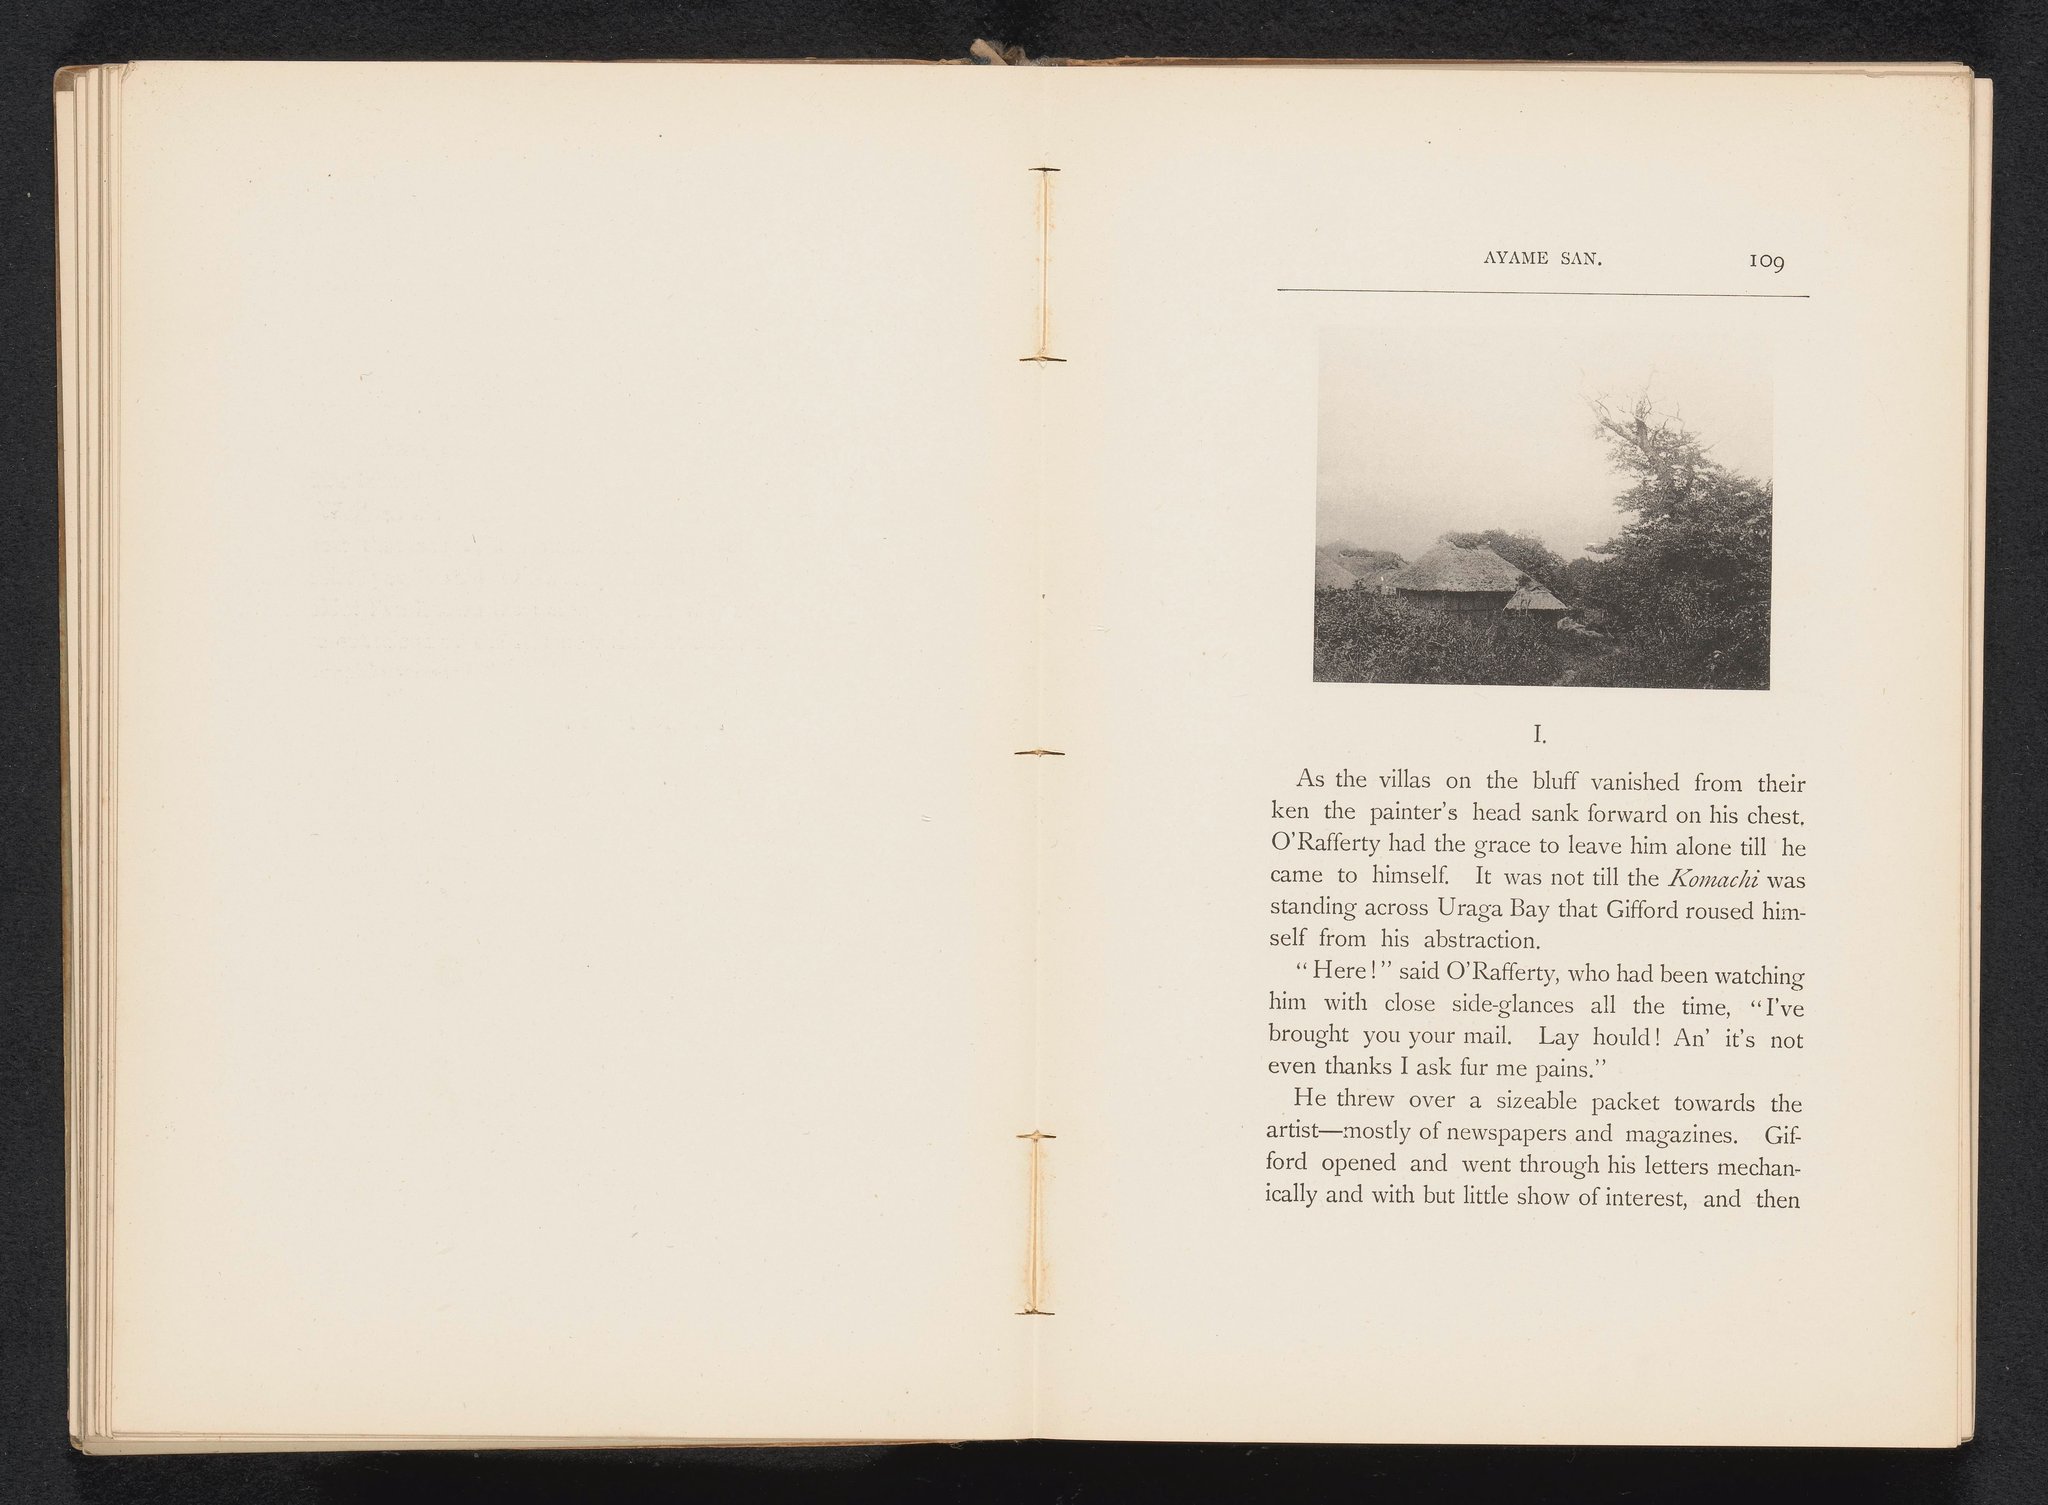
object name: photomechanical print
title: Gezicht op een woonhuis te Japan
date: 1882-1892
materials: paper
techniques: photograph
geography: japan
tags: housing, façade (of house or building)